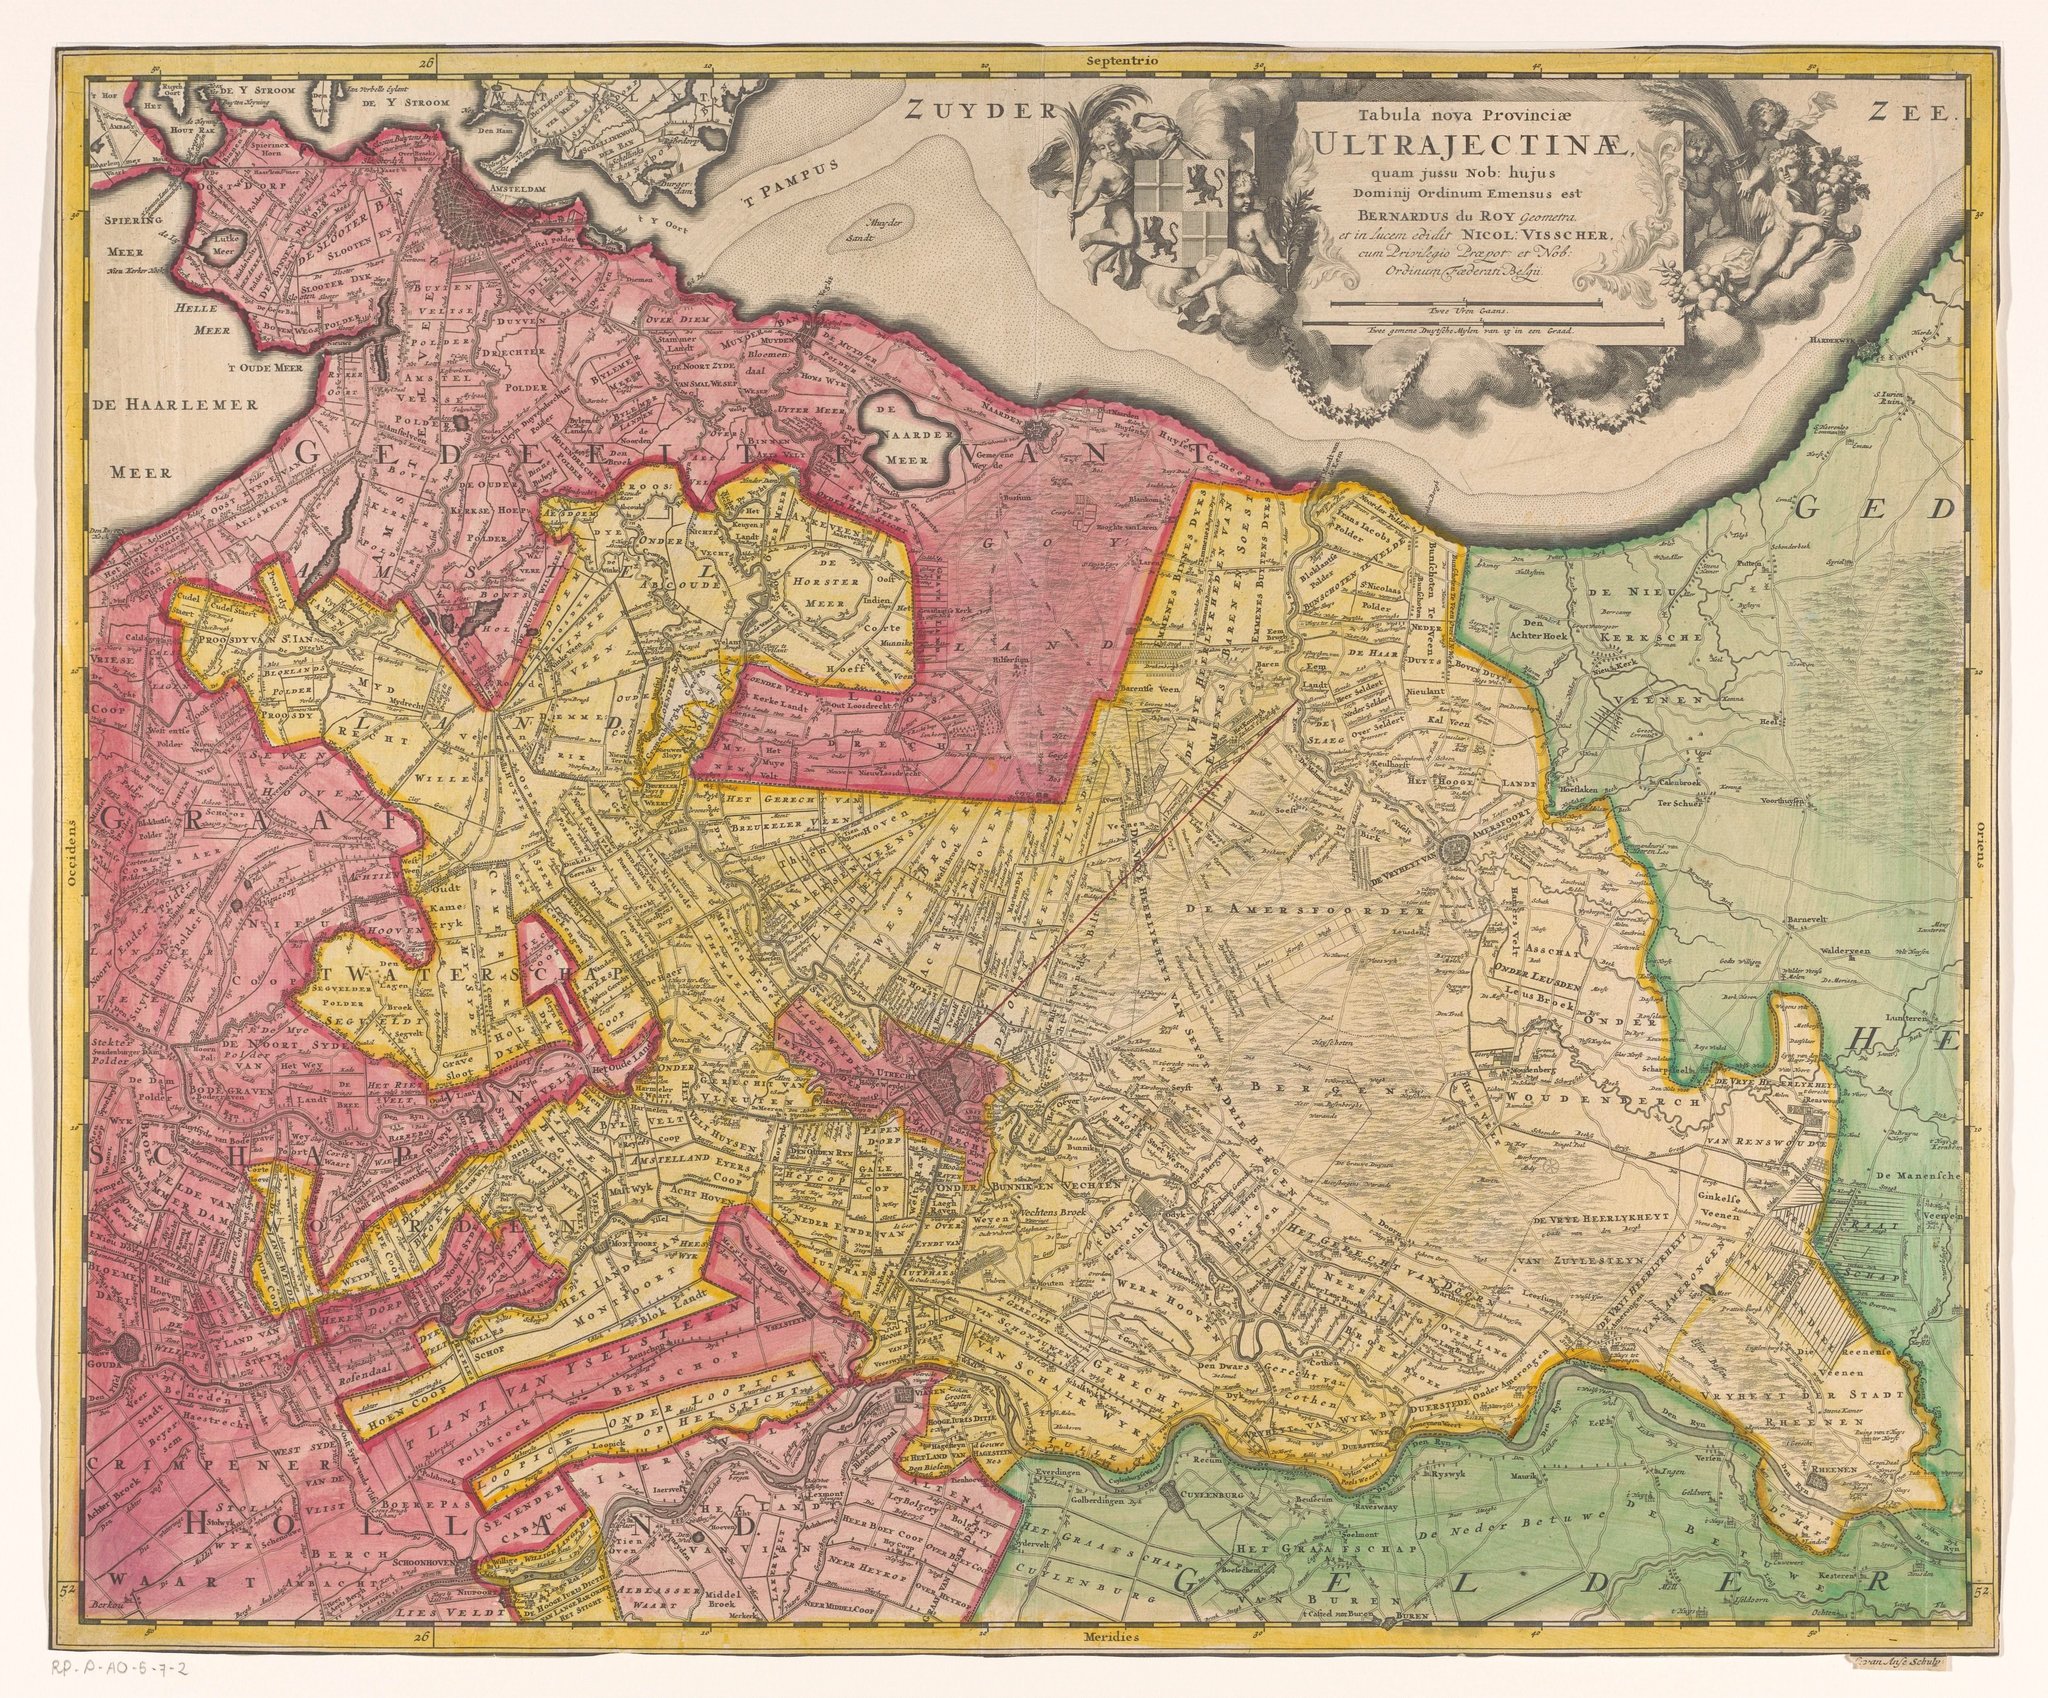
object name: map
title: Kaart van de provincie Utrecht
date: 1679-1682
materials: paper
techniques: engraving, etching, hand coloring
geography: utrecht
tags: coat of arms (as symbol of the state, etc.), maps of separate countries or regions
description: Prent ook gebruikt in: Atlas minor sive geographia compendiosa, qua orbis terrarum (…). Amsterdam: Nicolaes Visscher (II), [verschillende drukken vanaf 1683, onduidelijk in welke drukke(n) deze kaart is verschenen]. Mogelijk kon deze kaart uitgebreid worden met een kaart van de Veluwe (RP-P-AO-5-7-1B). Het is echter niet duidelijk of deze uitbreiding al bij de huidige staat werd uitgegeven of pas bij een latere staat van Pieter Schenk II of III.